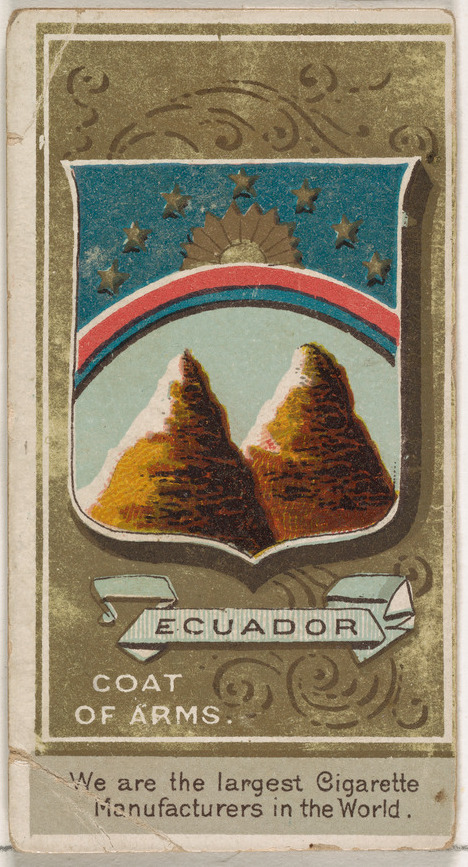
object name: print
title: President Caamano of Ecuador, from the Rulers, Flags, and Coats of Arms series (N126-2) issued by W. Duke, Sons & Co.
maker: w. duke, sons & co.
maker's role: publisher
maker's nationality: american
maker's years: 1870-1920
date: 1888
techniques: color lithograph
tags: men,portraits,coat of arms,flags